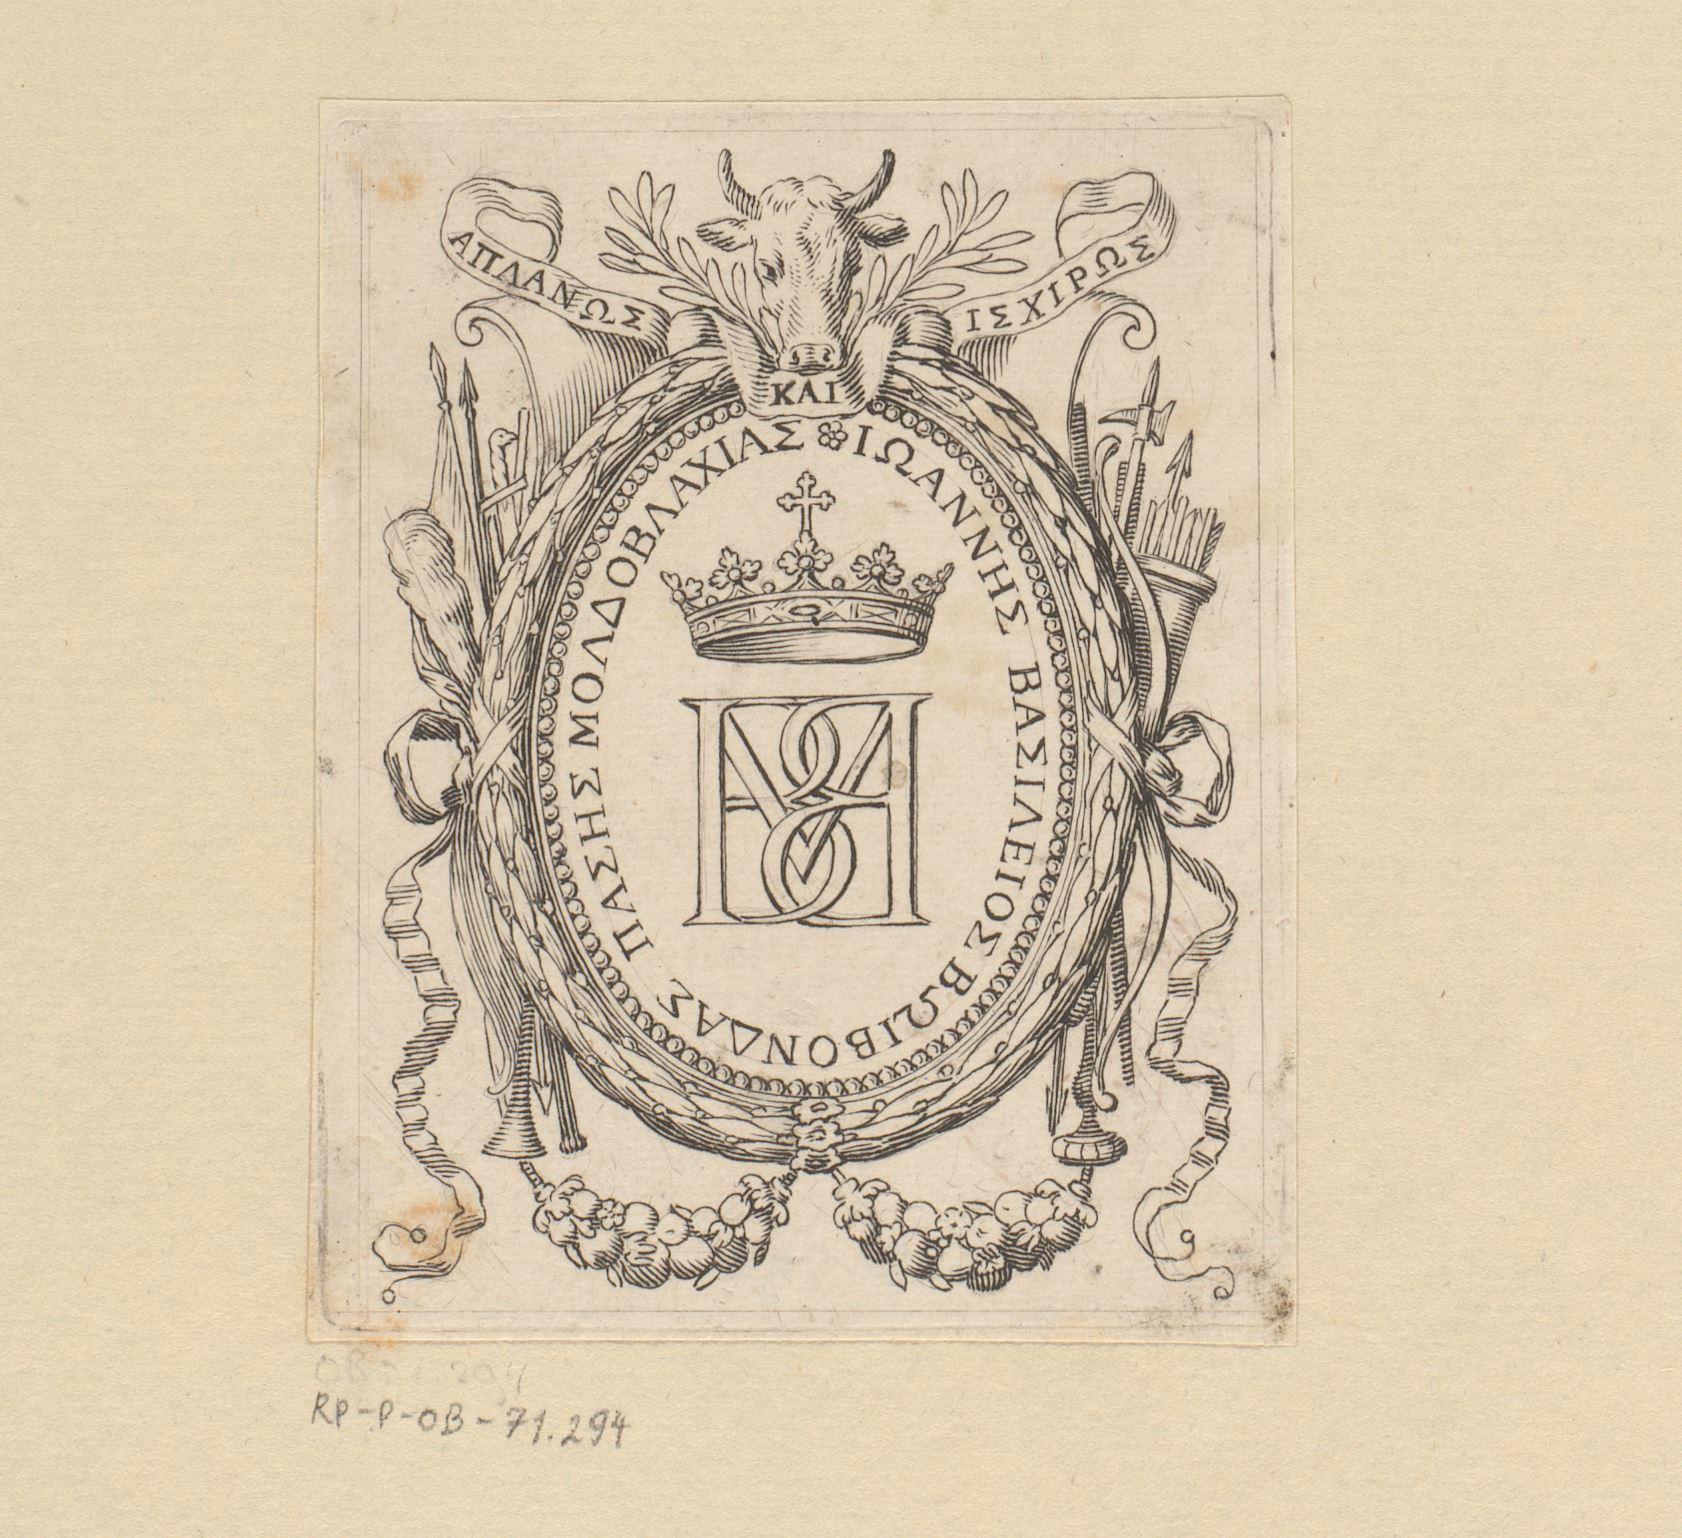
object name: print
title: Krans met gekroonde letters en hoofd van een koe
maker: claude mellan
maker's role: draughtsman, print maker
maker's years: 1598-1688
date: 1608-1688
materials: paper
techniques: engraving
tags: crown (symbol of sovereignty)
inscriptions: collector's mark: Lugt 240